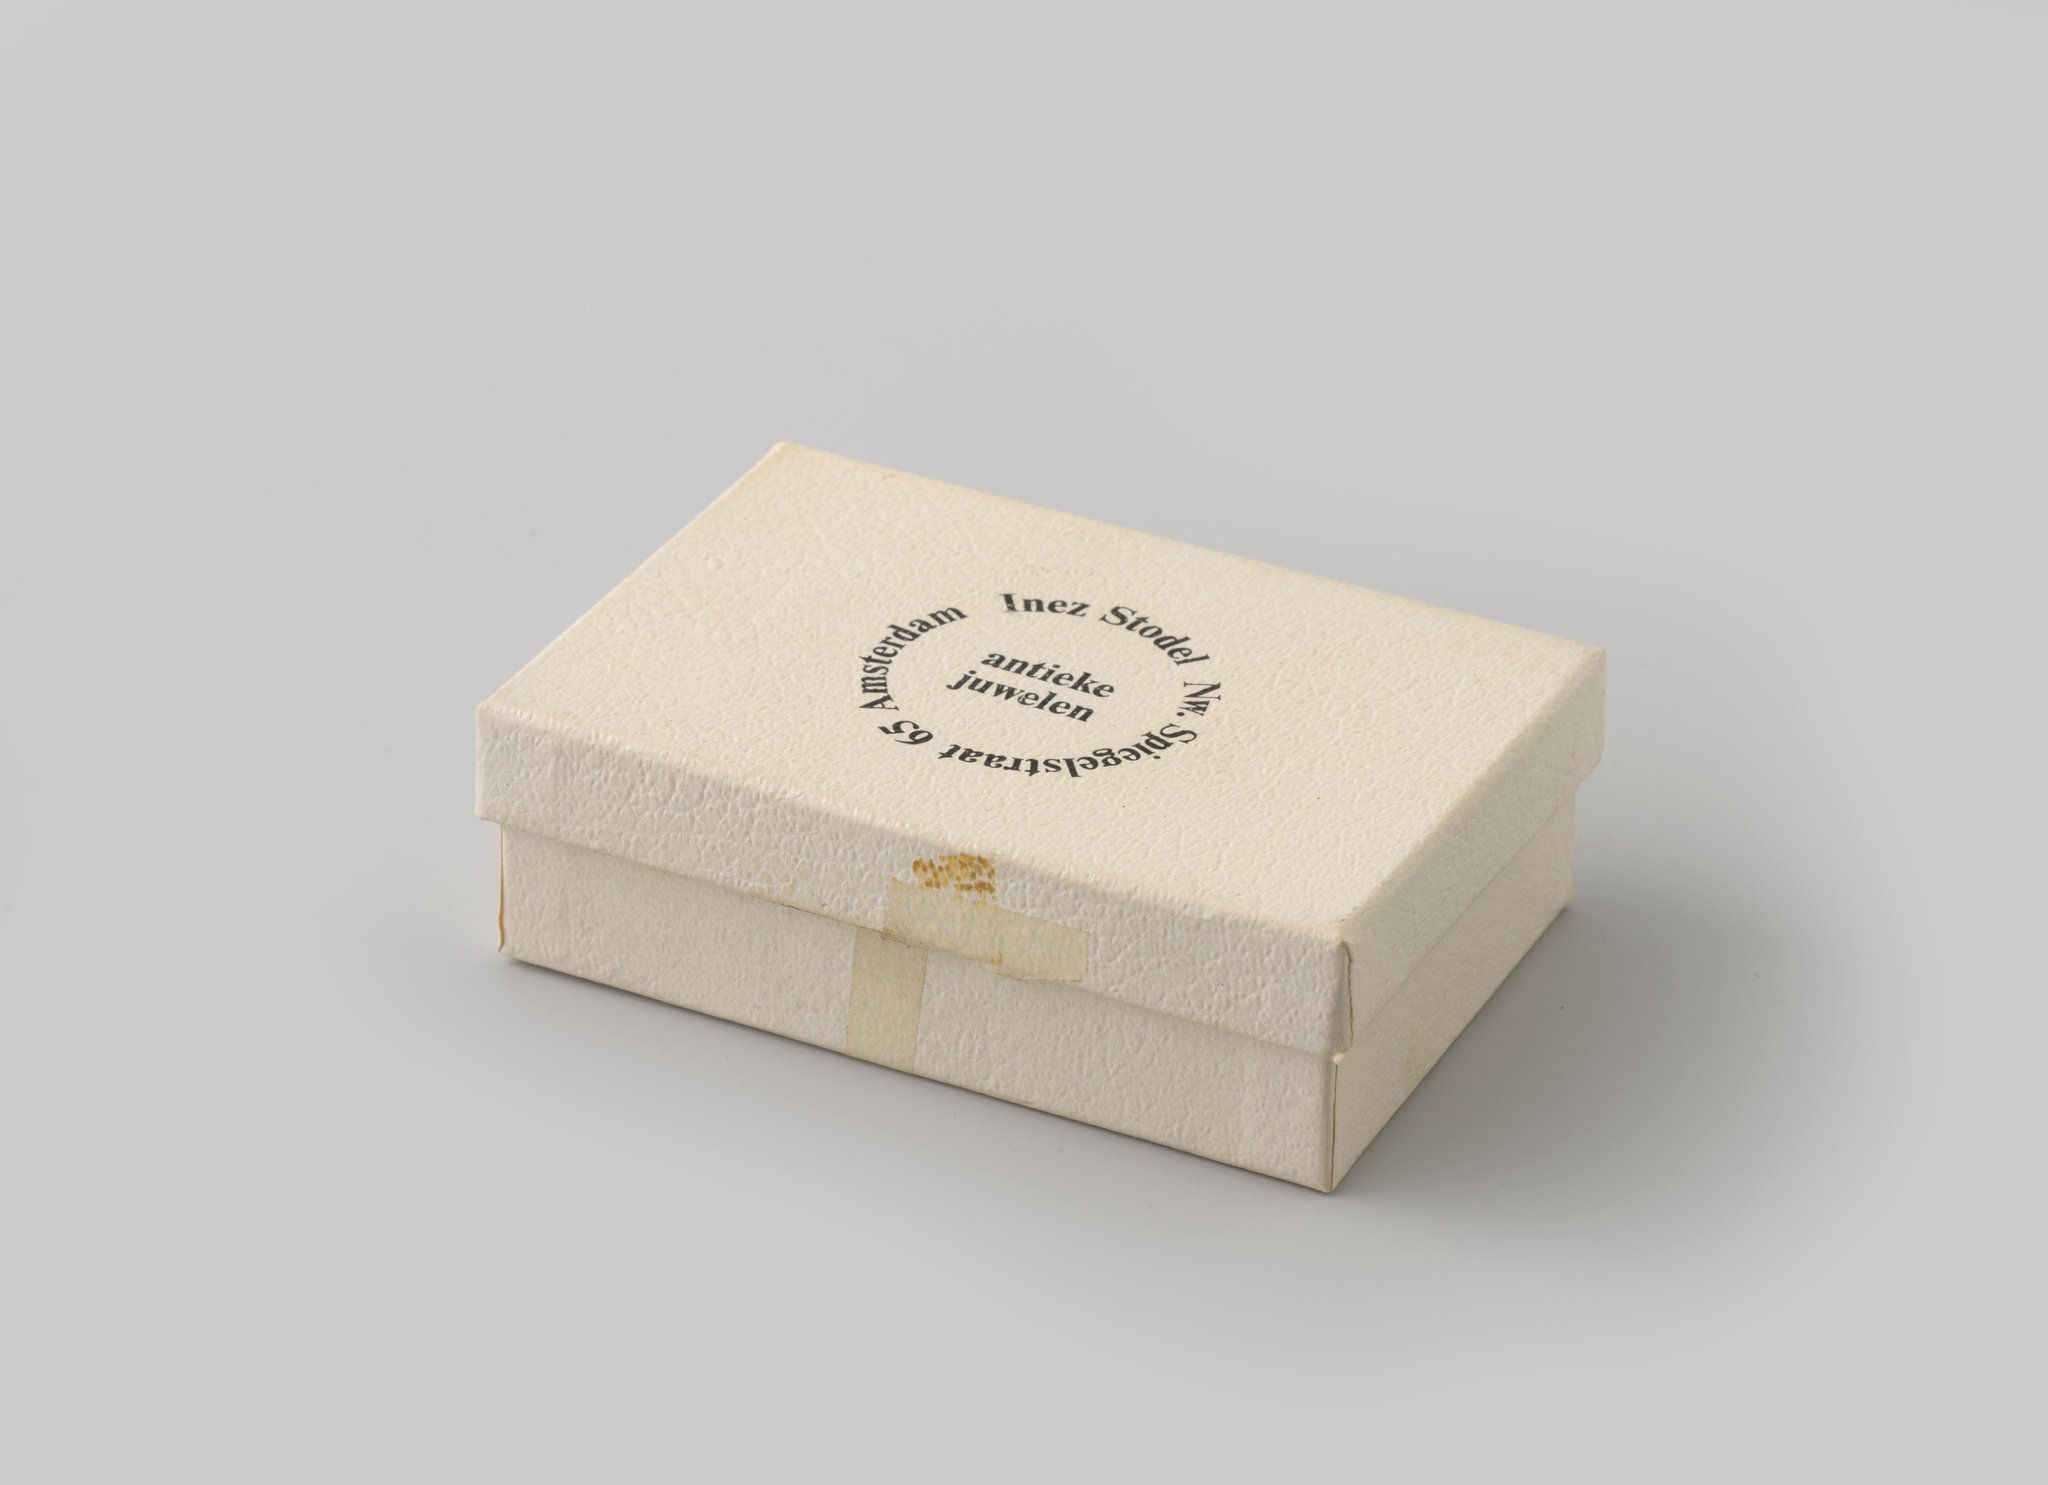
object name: juwelendoos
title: Witte rechthoekige kartonnen juwelendoos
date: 1970-1975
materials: cardboard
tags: flowers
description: Witte kartonnen juwelendoos voor reukflacon. Op deksel opdruk van Inez Stodel.